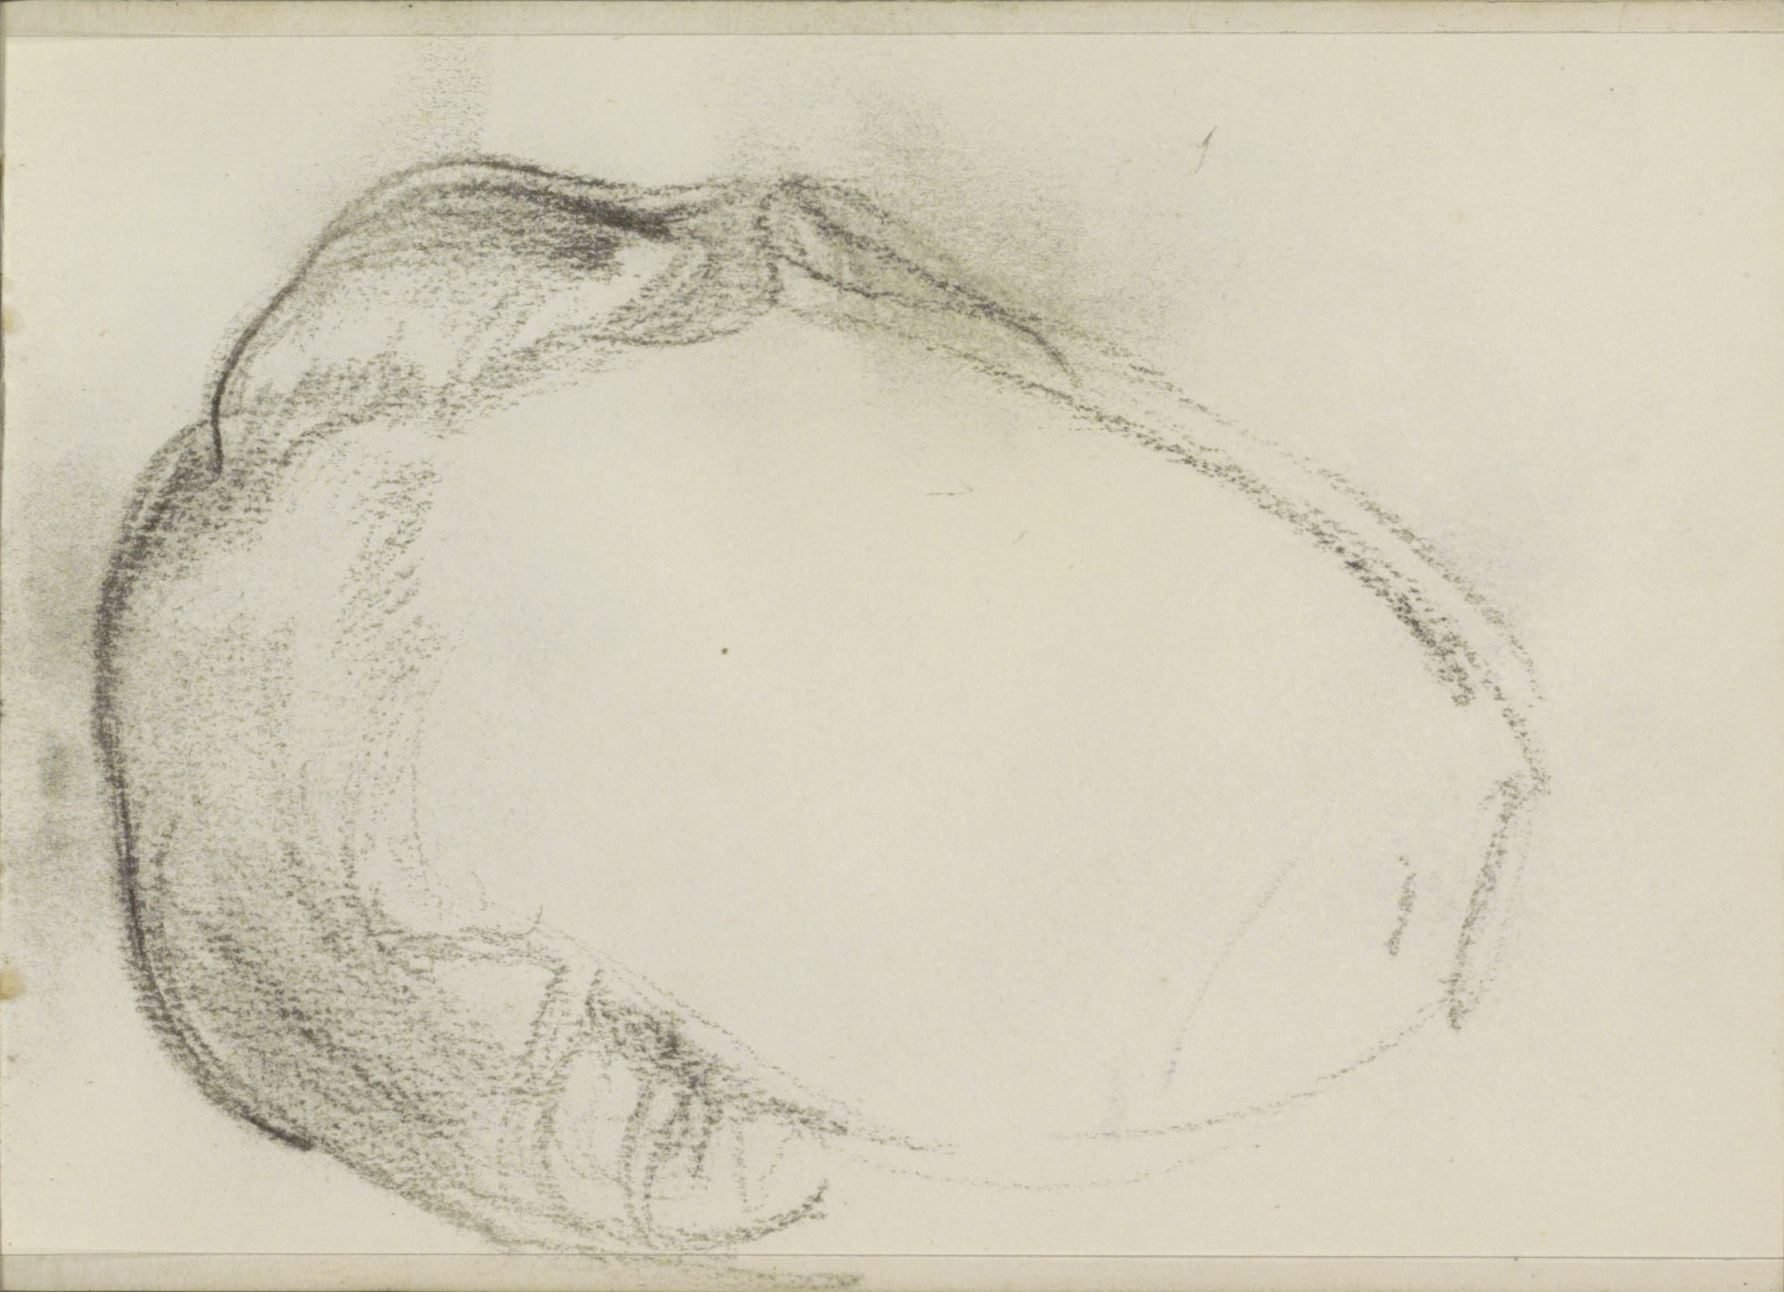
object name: sketchbook leaf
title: Kort glad kapsel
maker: a.a.l. de grammont-hubrecht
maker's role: draughtsman, painter, print maker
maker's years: 1855-1913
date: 1865-1913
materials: charcoal, paper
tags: styles of hairdress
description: Blad 18 recto uit een schetsboek met 38 bladen.